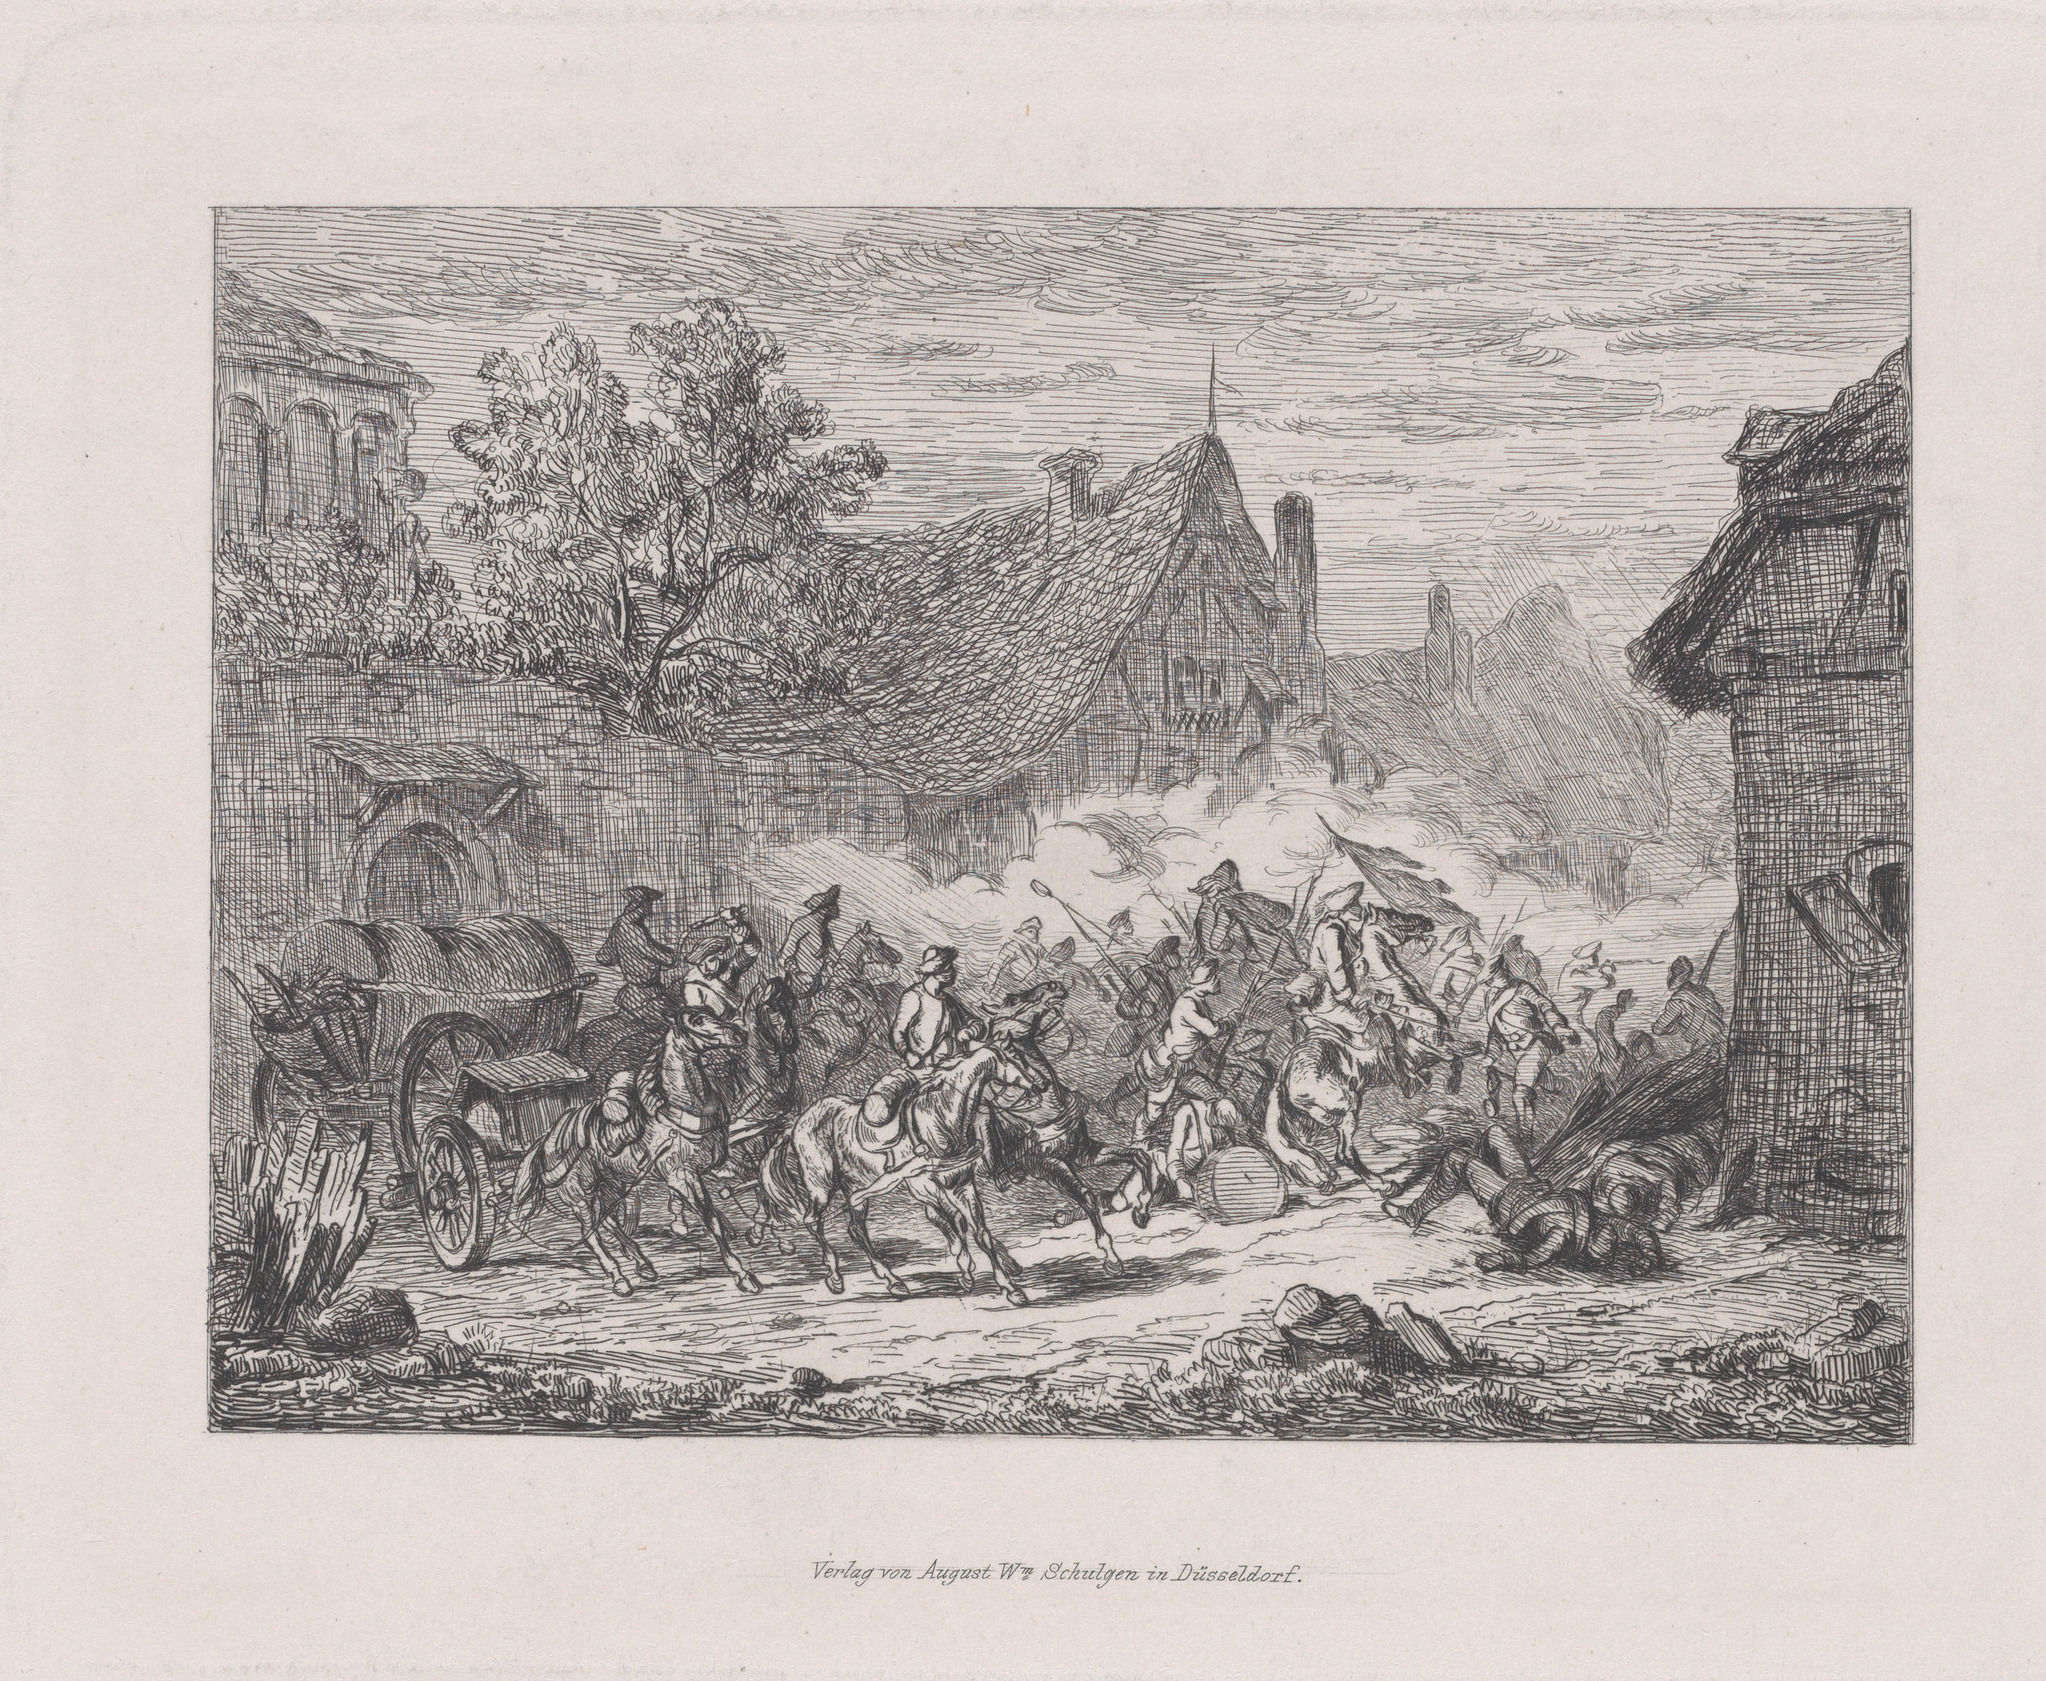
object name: print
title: Military scene with a battle in a village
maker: august beck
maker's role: artist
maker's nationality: swiss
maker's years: 1823-1872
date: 1840-1860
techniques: etching